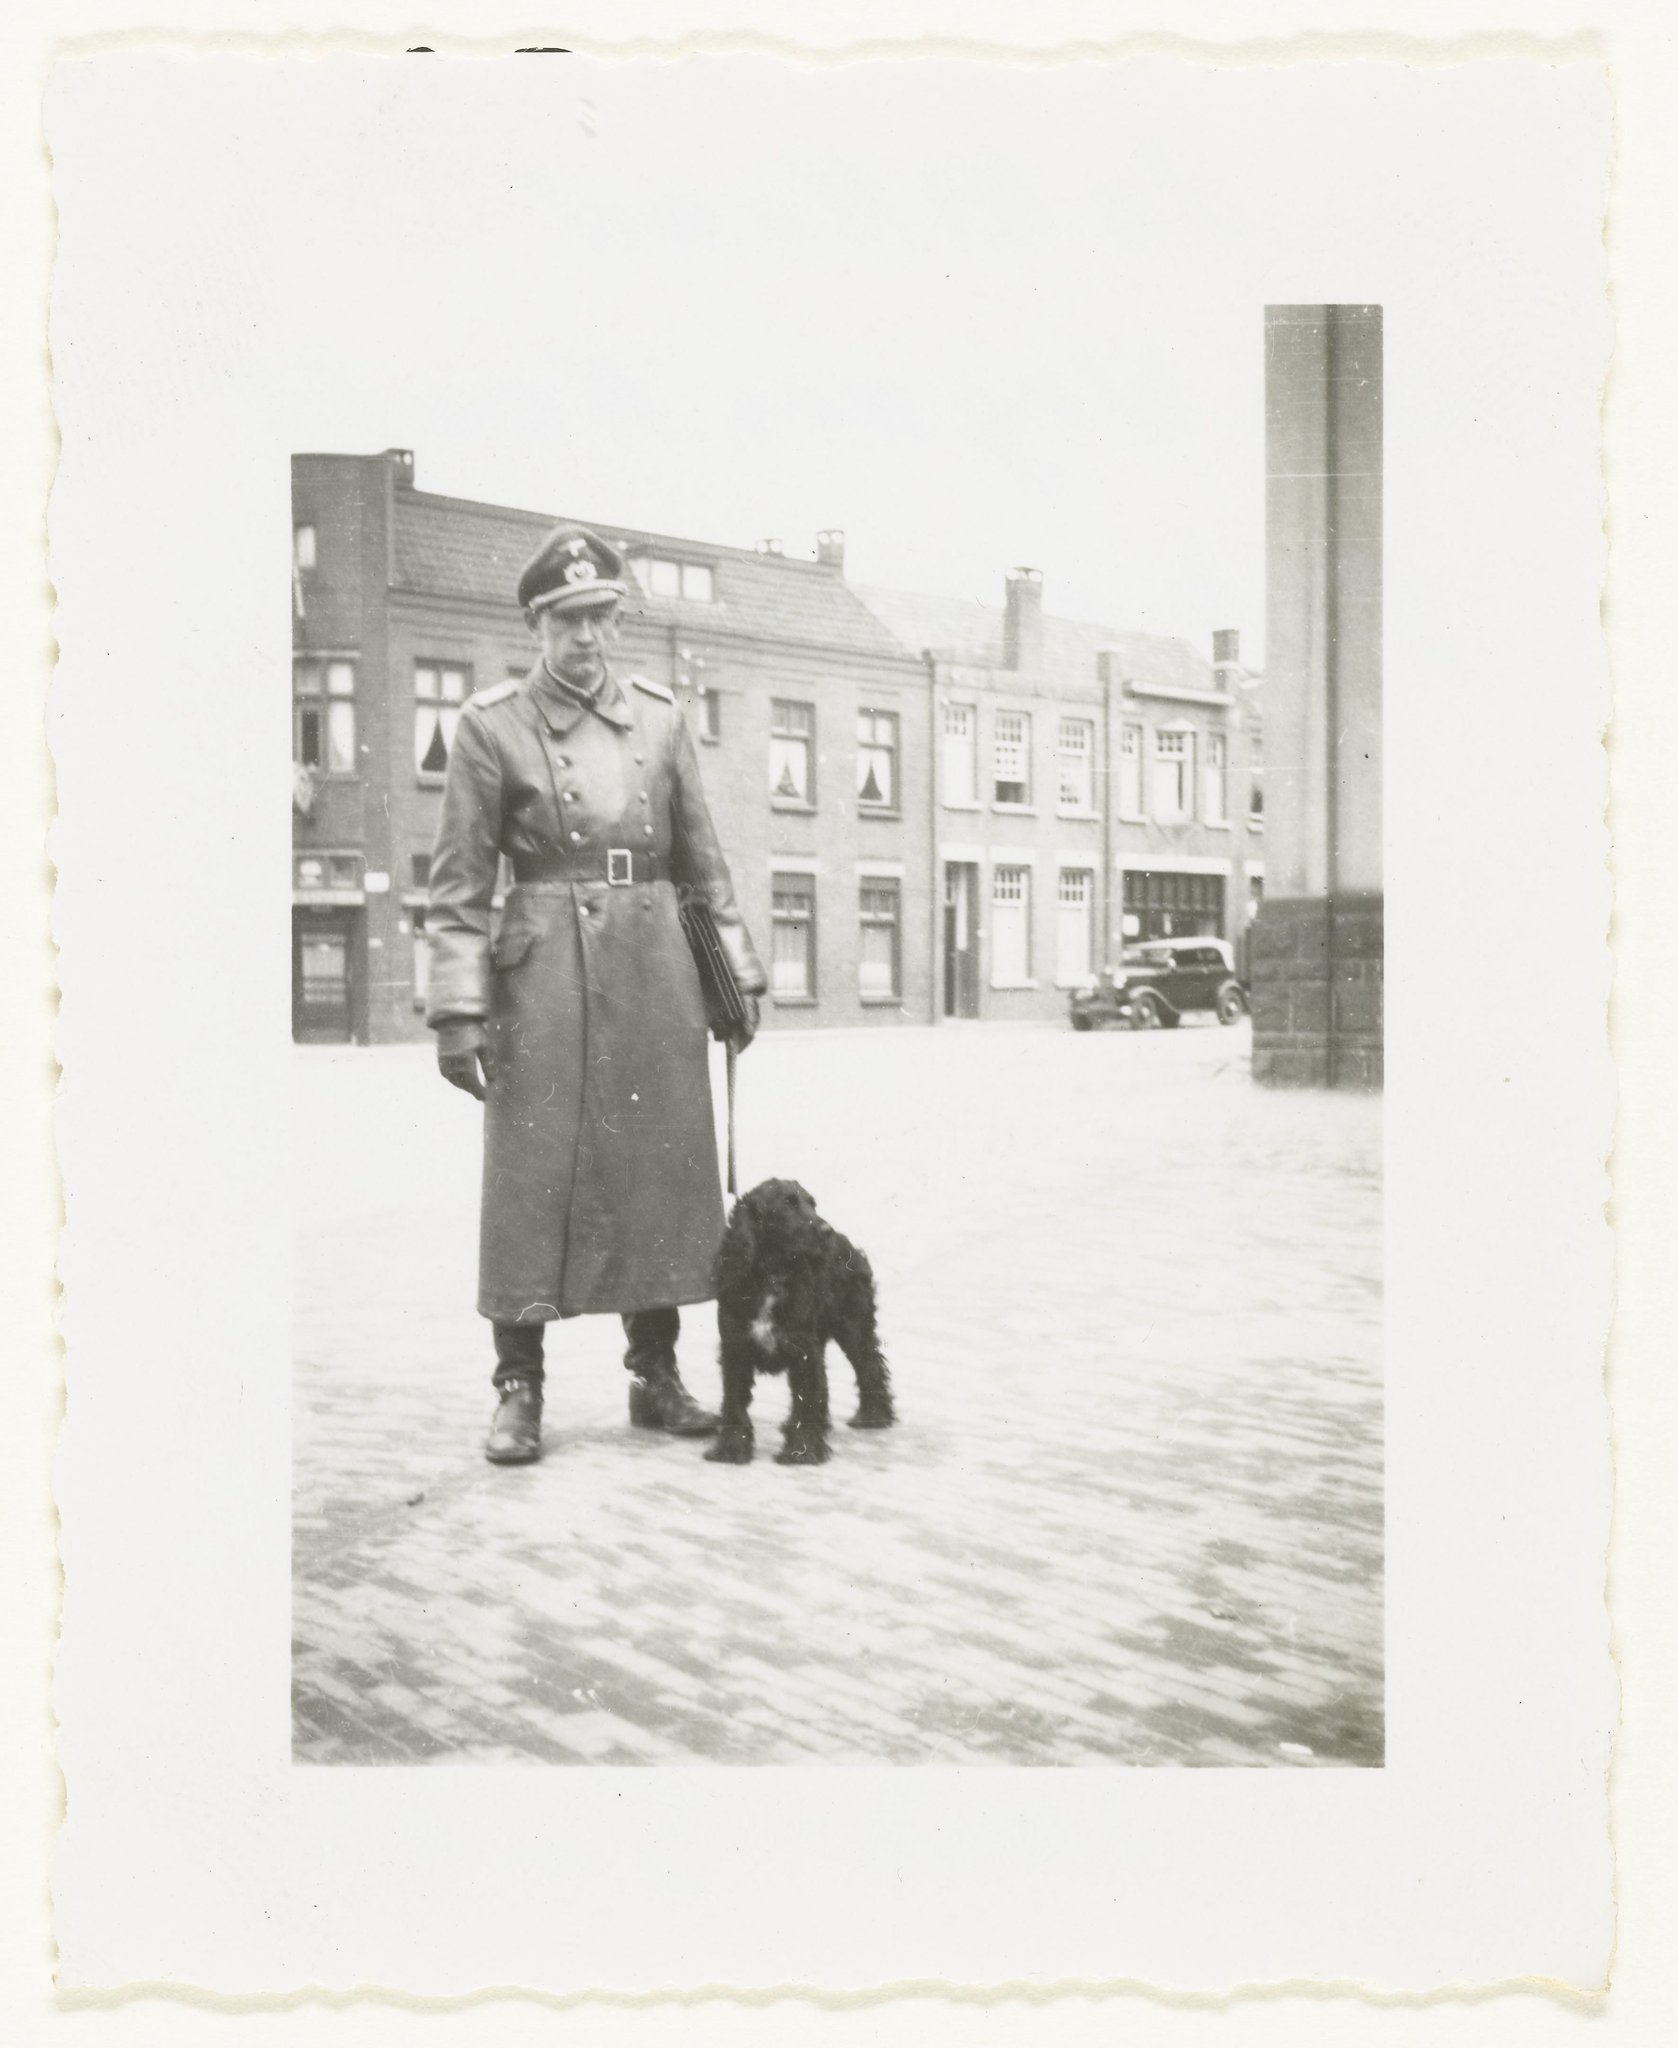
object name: photograph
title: Wehrmacht militair met hond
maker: Anonymous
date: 1941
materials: photographic support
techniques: gelatin silver print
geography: netherlands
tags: occupation ~ war, netherlands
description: Een Wehrmacht militair, luitenant, in leren jas met pet, met een hond in een straat. Achertop staat: Ltn. Wegner kauft sich einen Hund.